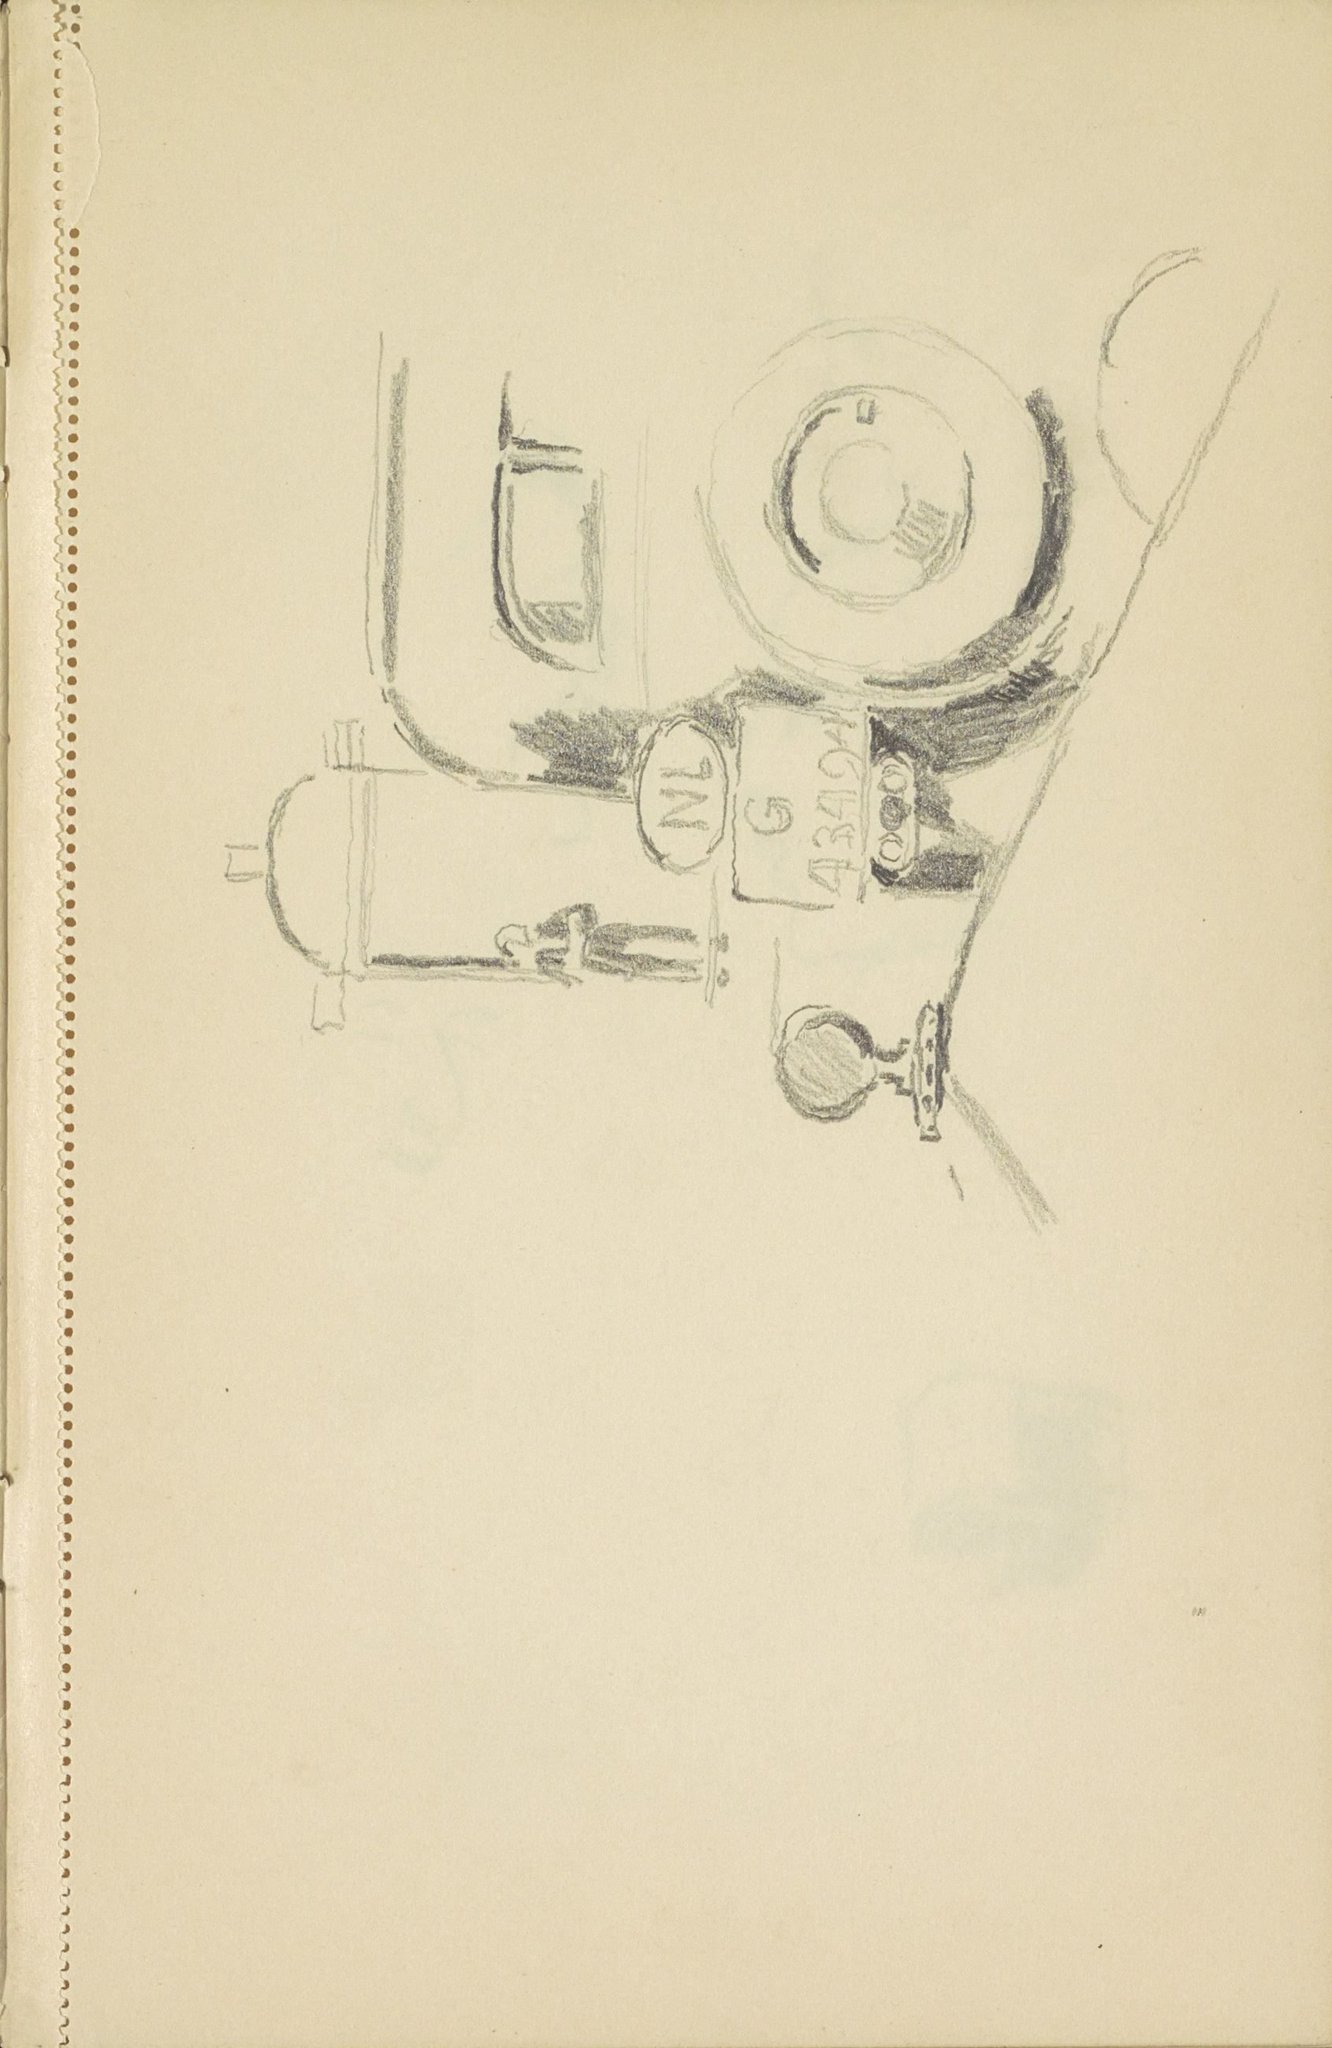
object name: sketchbook leaf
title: Achterkant van een auto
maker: cornelis vreedenburgh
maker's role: draughtsman, print maker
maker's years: 1880-1946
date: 1890-1946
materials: paper, pencil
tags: automobile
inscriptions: annotation: ‘NL/ G/ 43494’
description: Gezien vanuit een auto. Op de achtergrond een figuur bij een poort of deuropening. Blad 44 recto uit een schetsboek met 73 bladen.